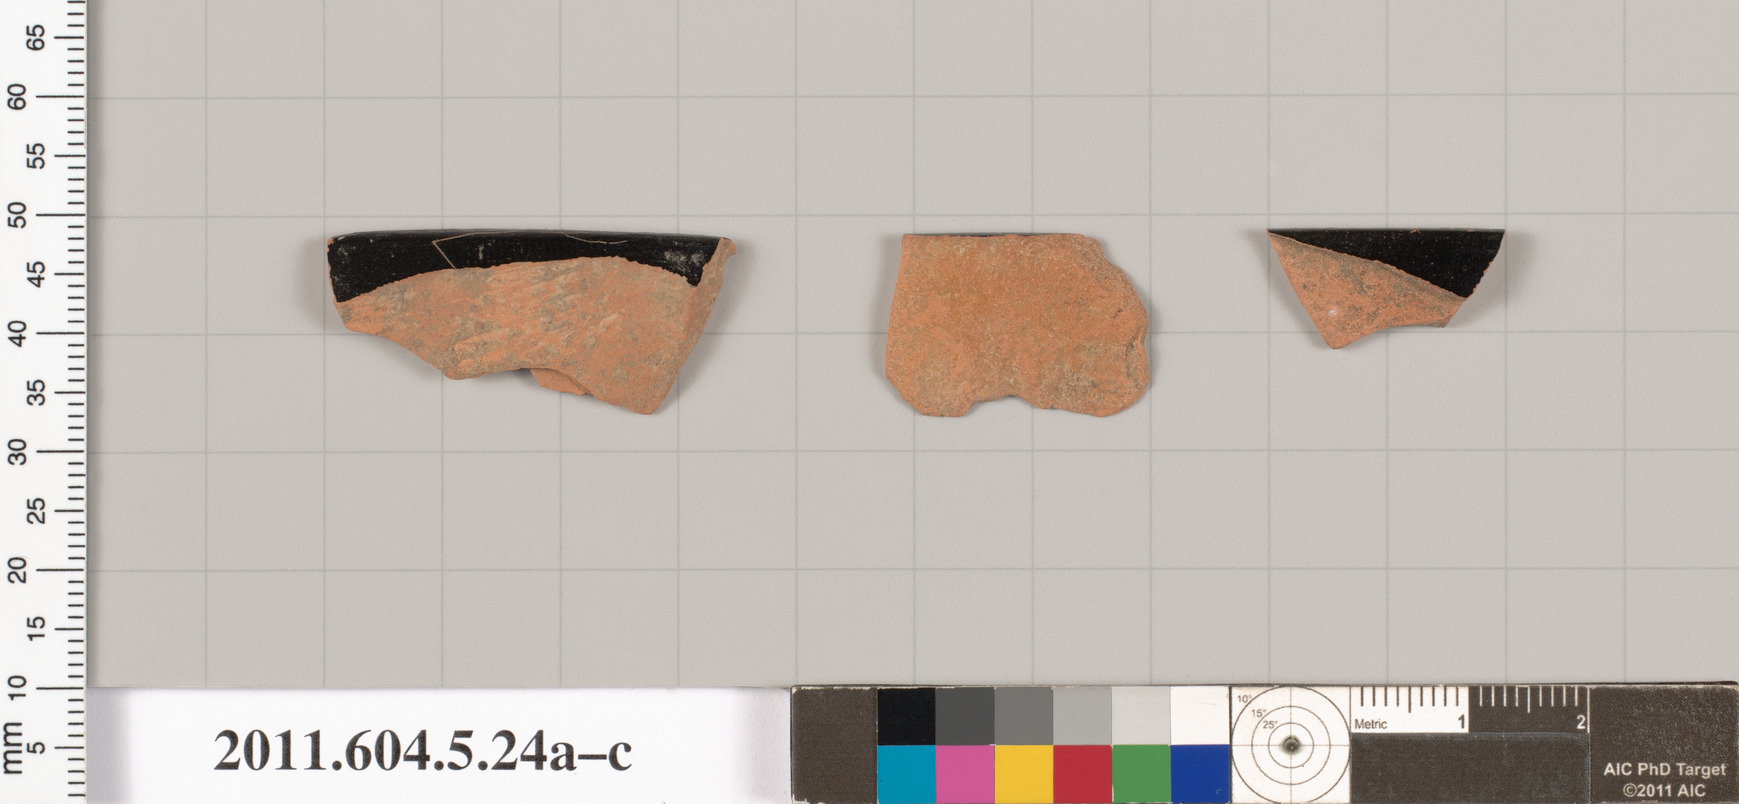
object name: kylix fragment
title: Terracotta rim fragments of kylikes (drinking cups)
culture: greek, attic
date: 500-401 BCE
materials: terracotta